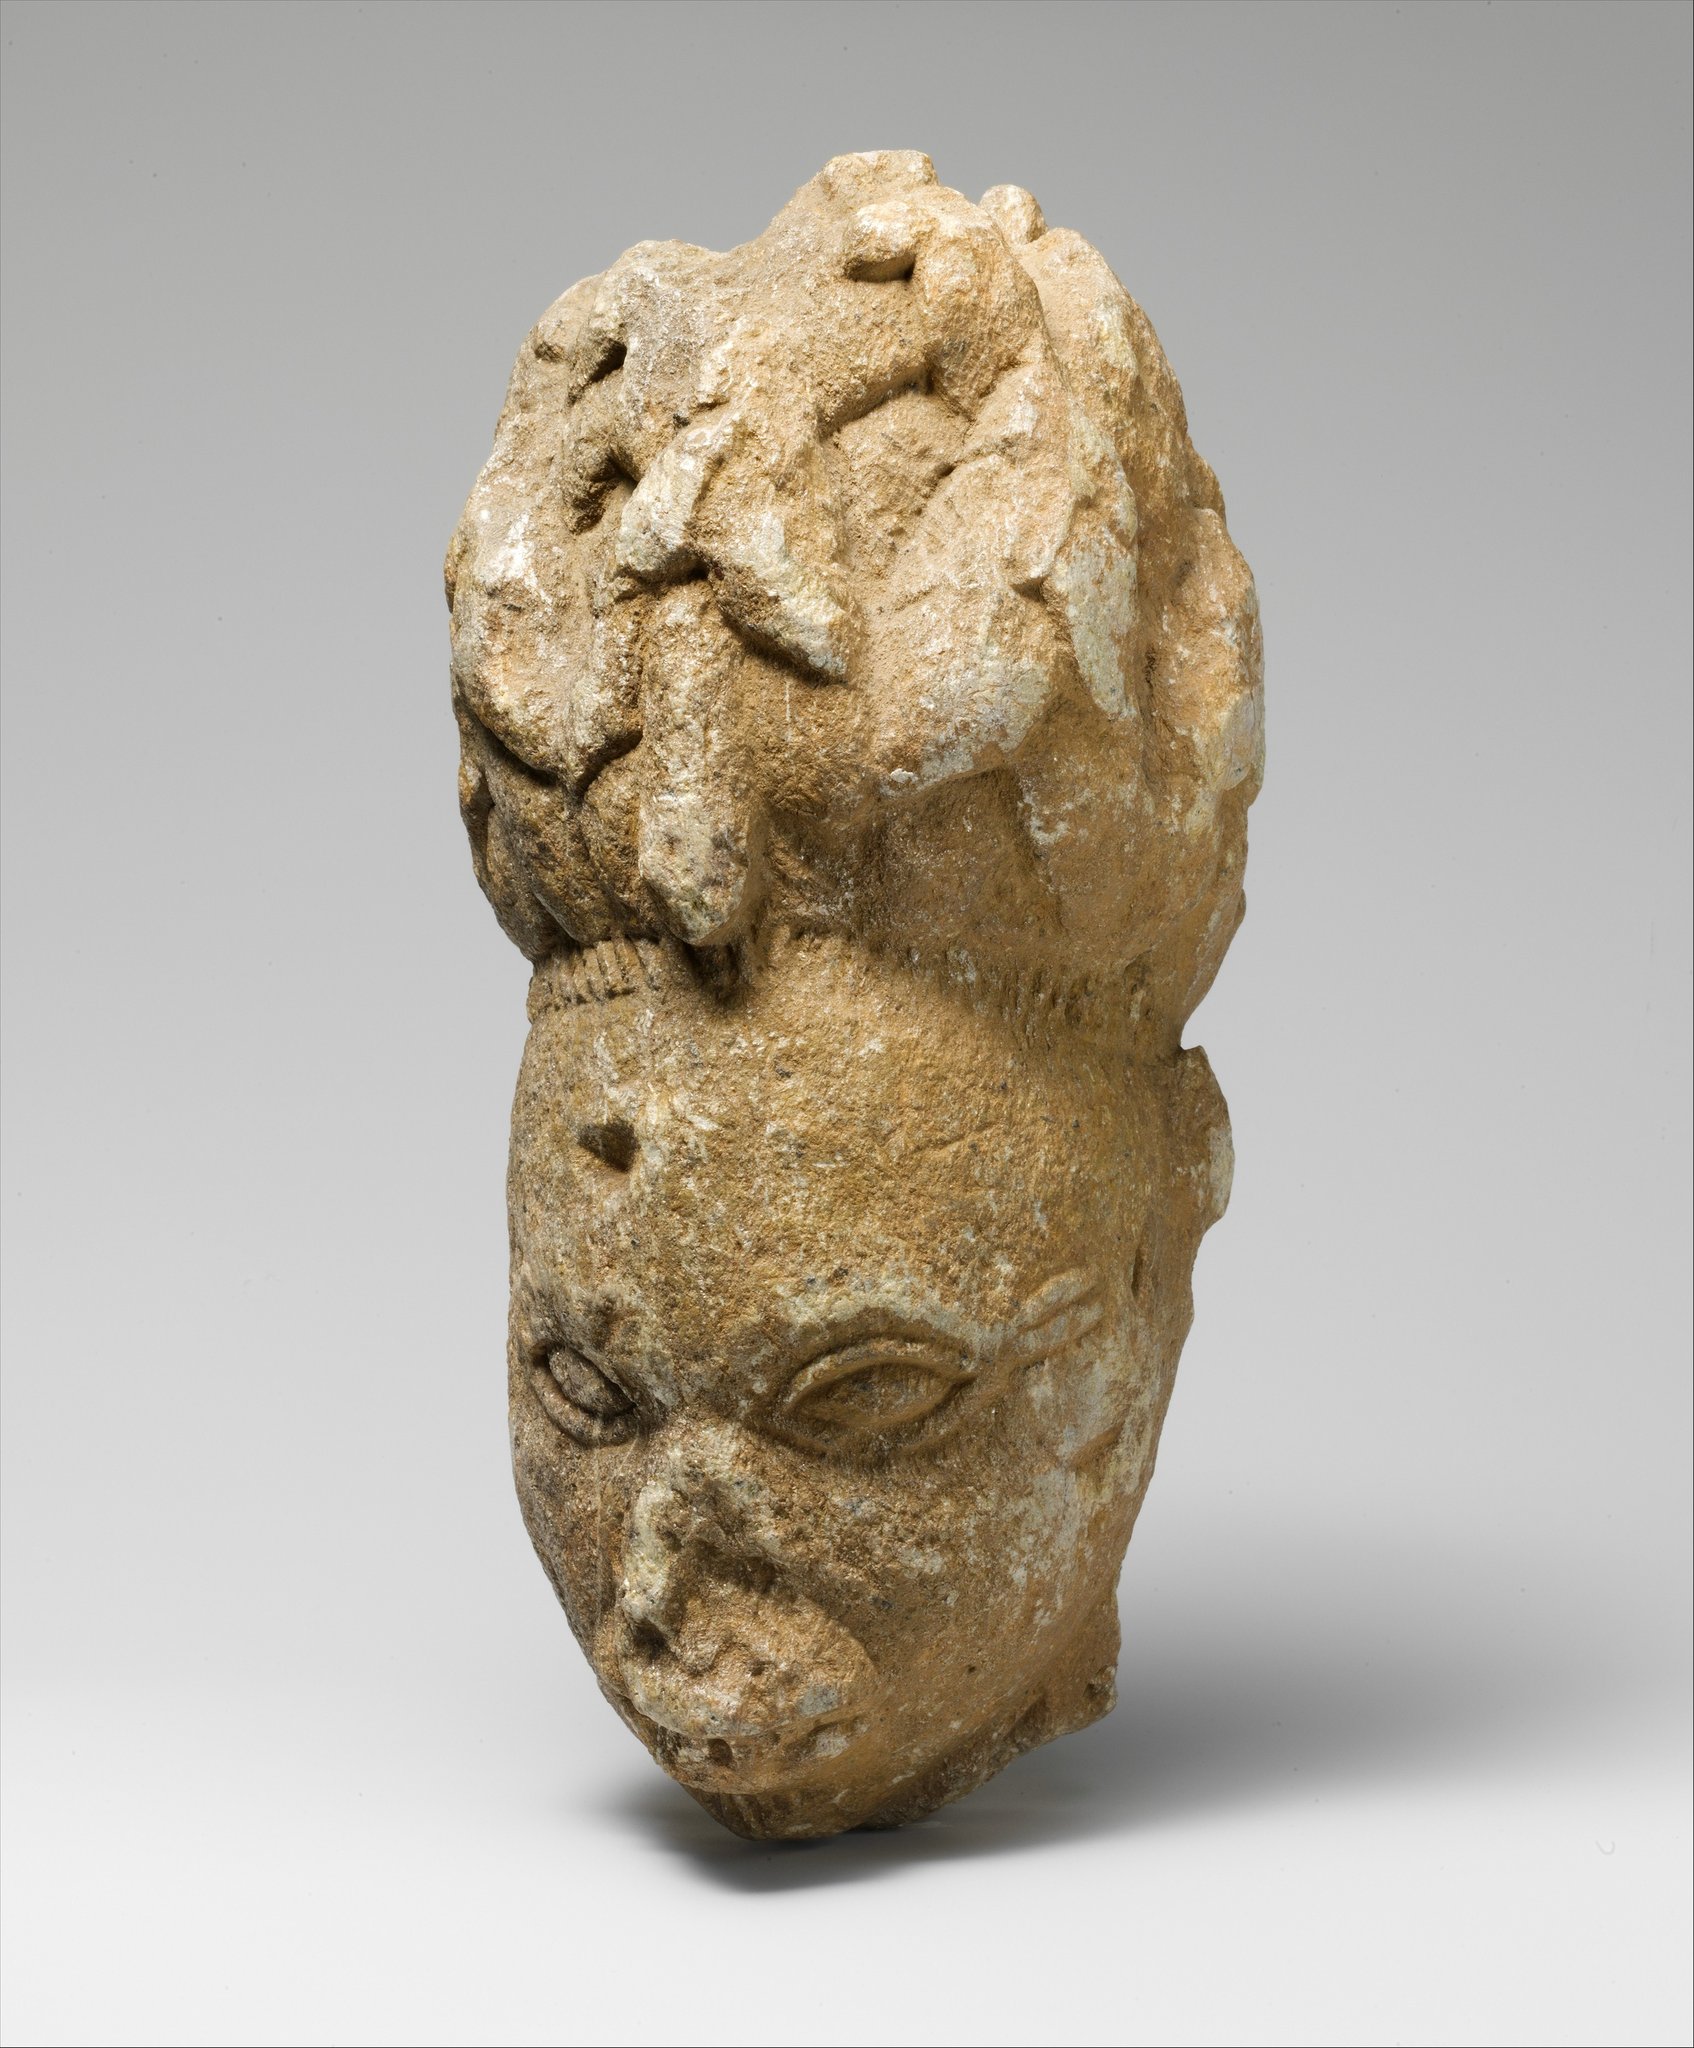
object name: head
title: Head from a figure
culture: yoruba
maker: yoruba artist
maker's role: artist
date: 1101-1500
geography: nigeria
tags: heads